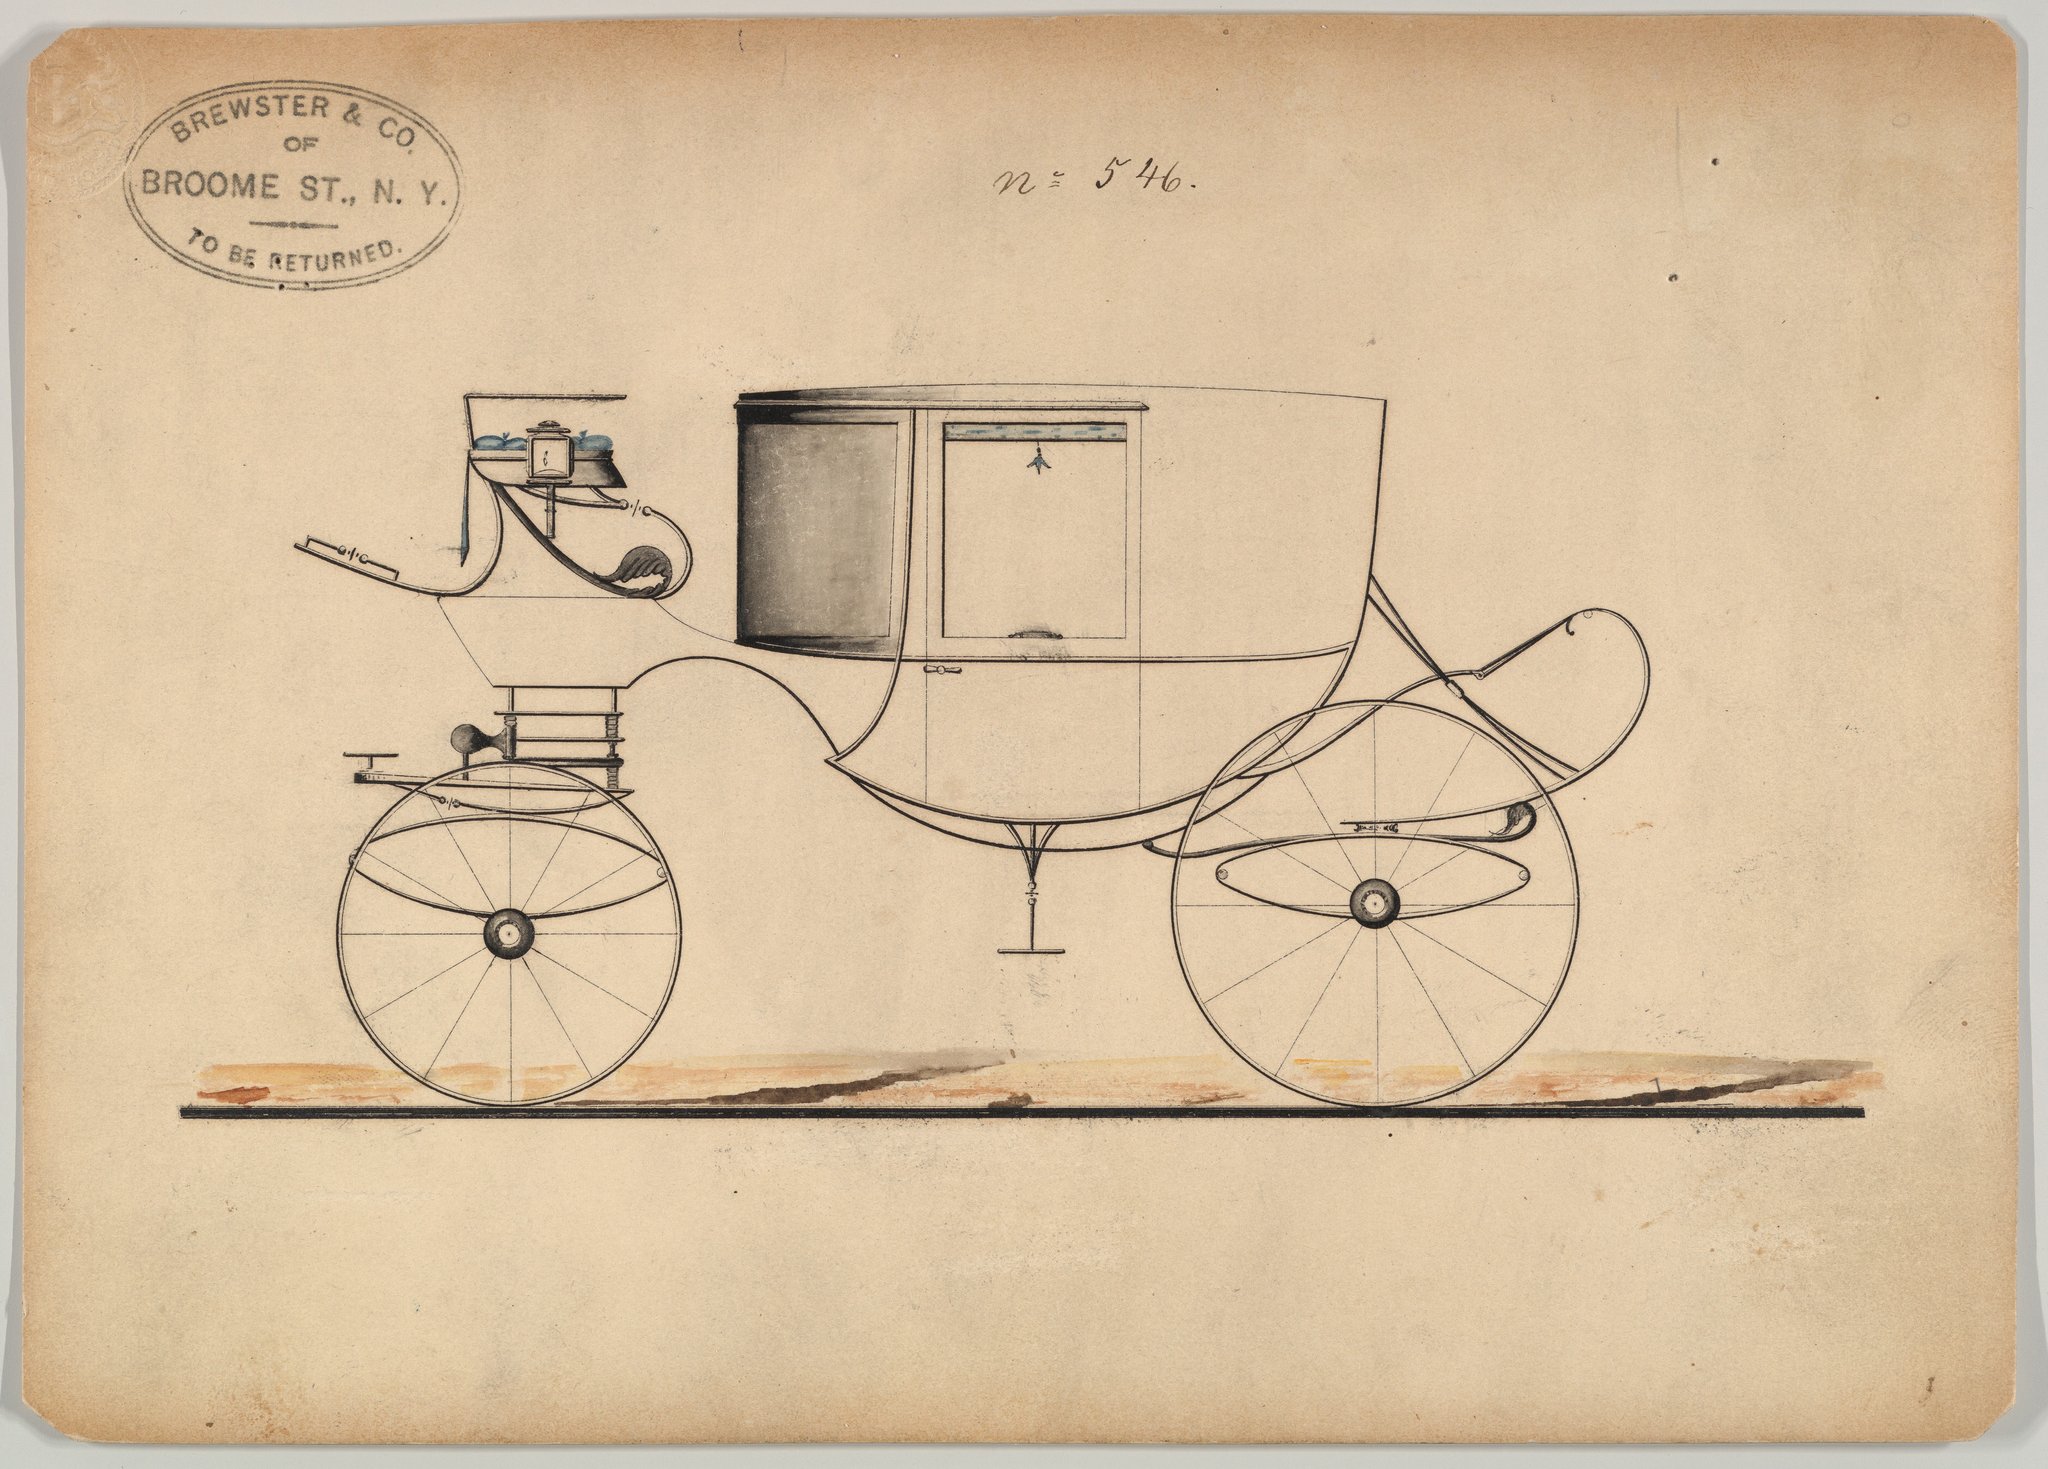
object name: drawing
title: Clarence # 546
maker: brewster & co.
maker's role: manufacturer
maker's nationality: american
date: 1850-1870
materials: ink, watercolor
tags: carriages